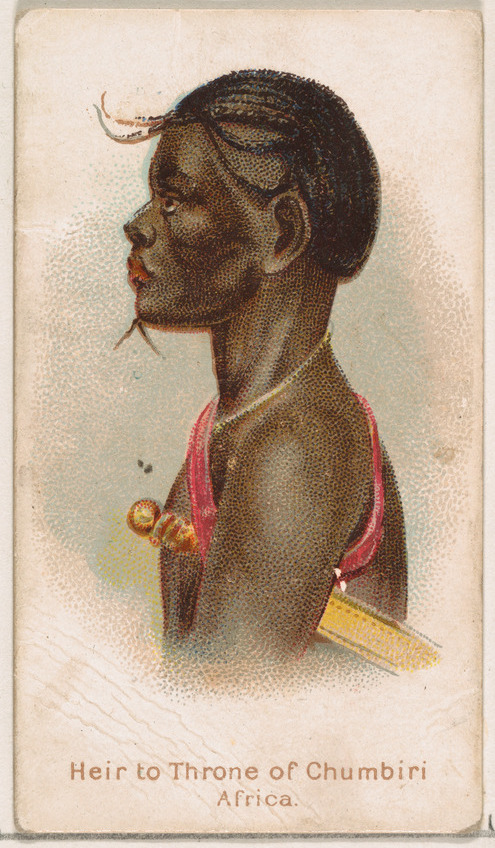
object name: print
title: Heir to the Throne of Chumbiri, Africa, from the Savage and Semi-Barbarous Chiefs and Rulers series (N189) issued by Wm. S. Kimball & Co.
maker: william s. kimball & company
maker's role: publisher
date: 1888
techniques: color lithograph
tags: men,profiles